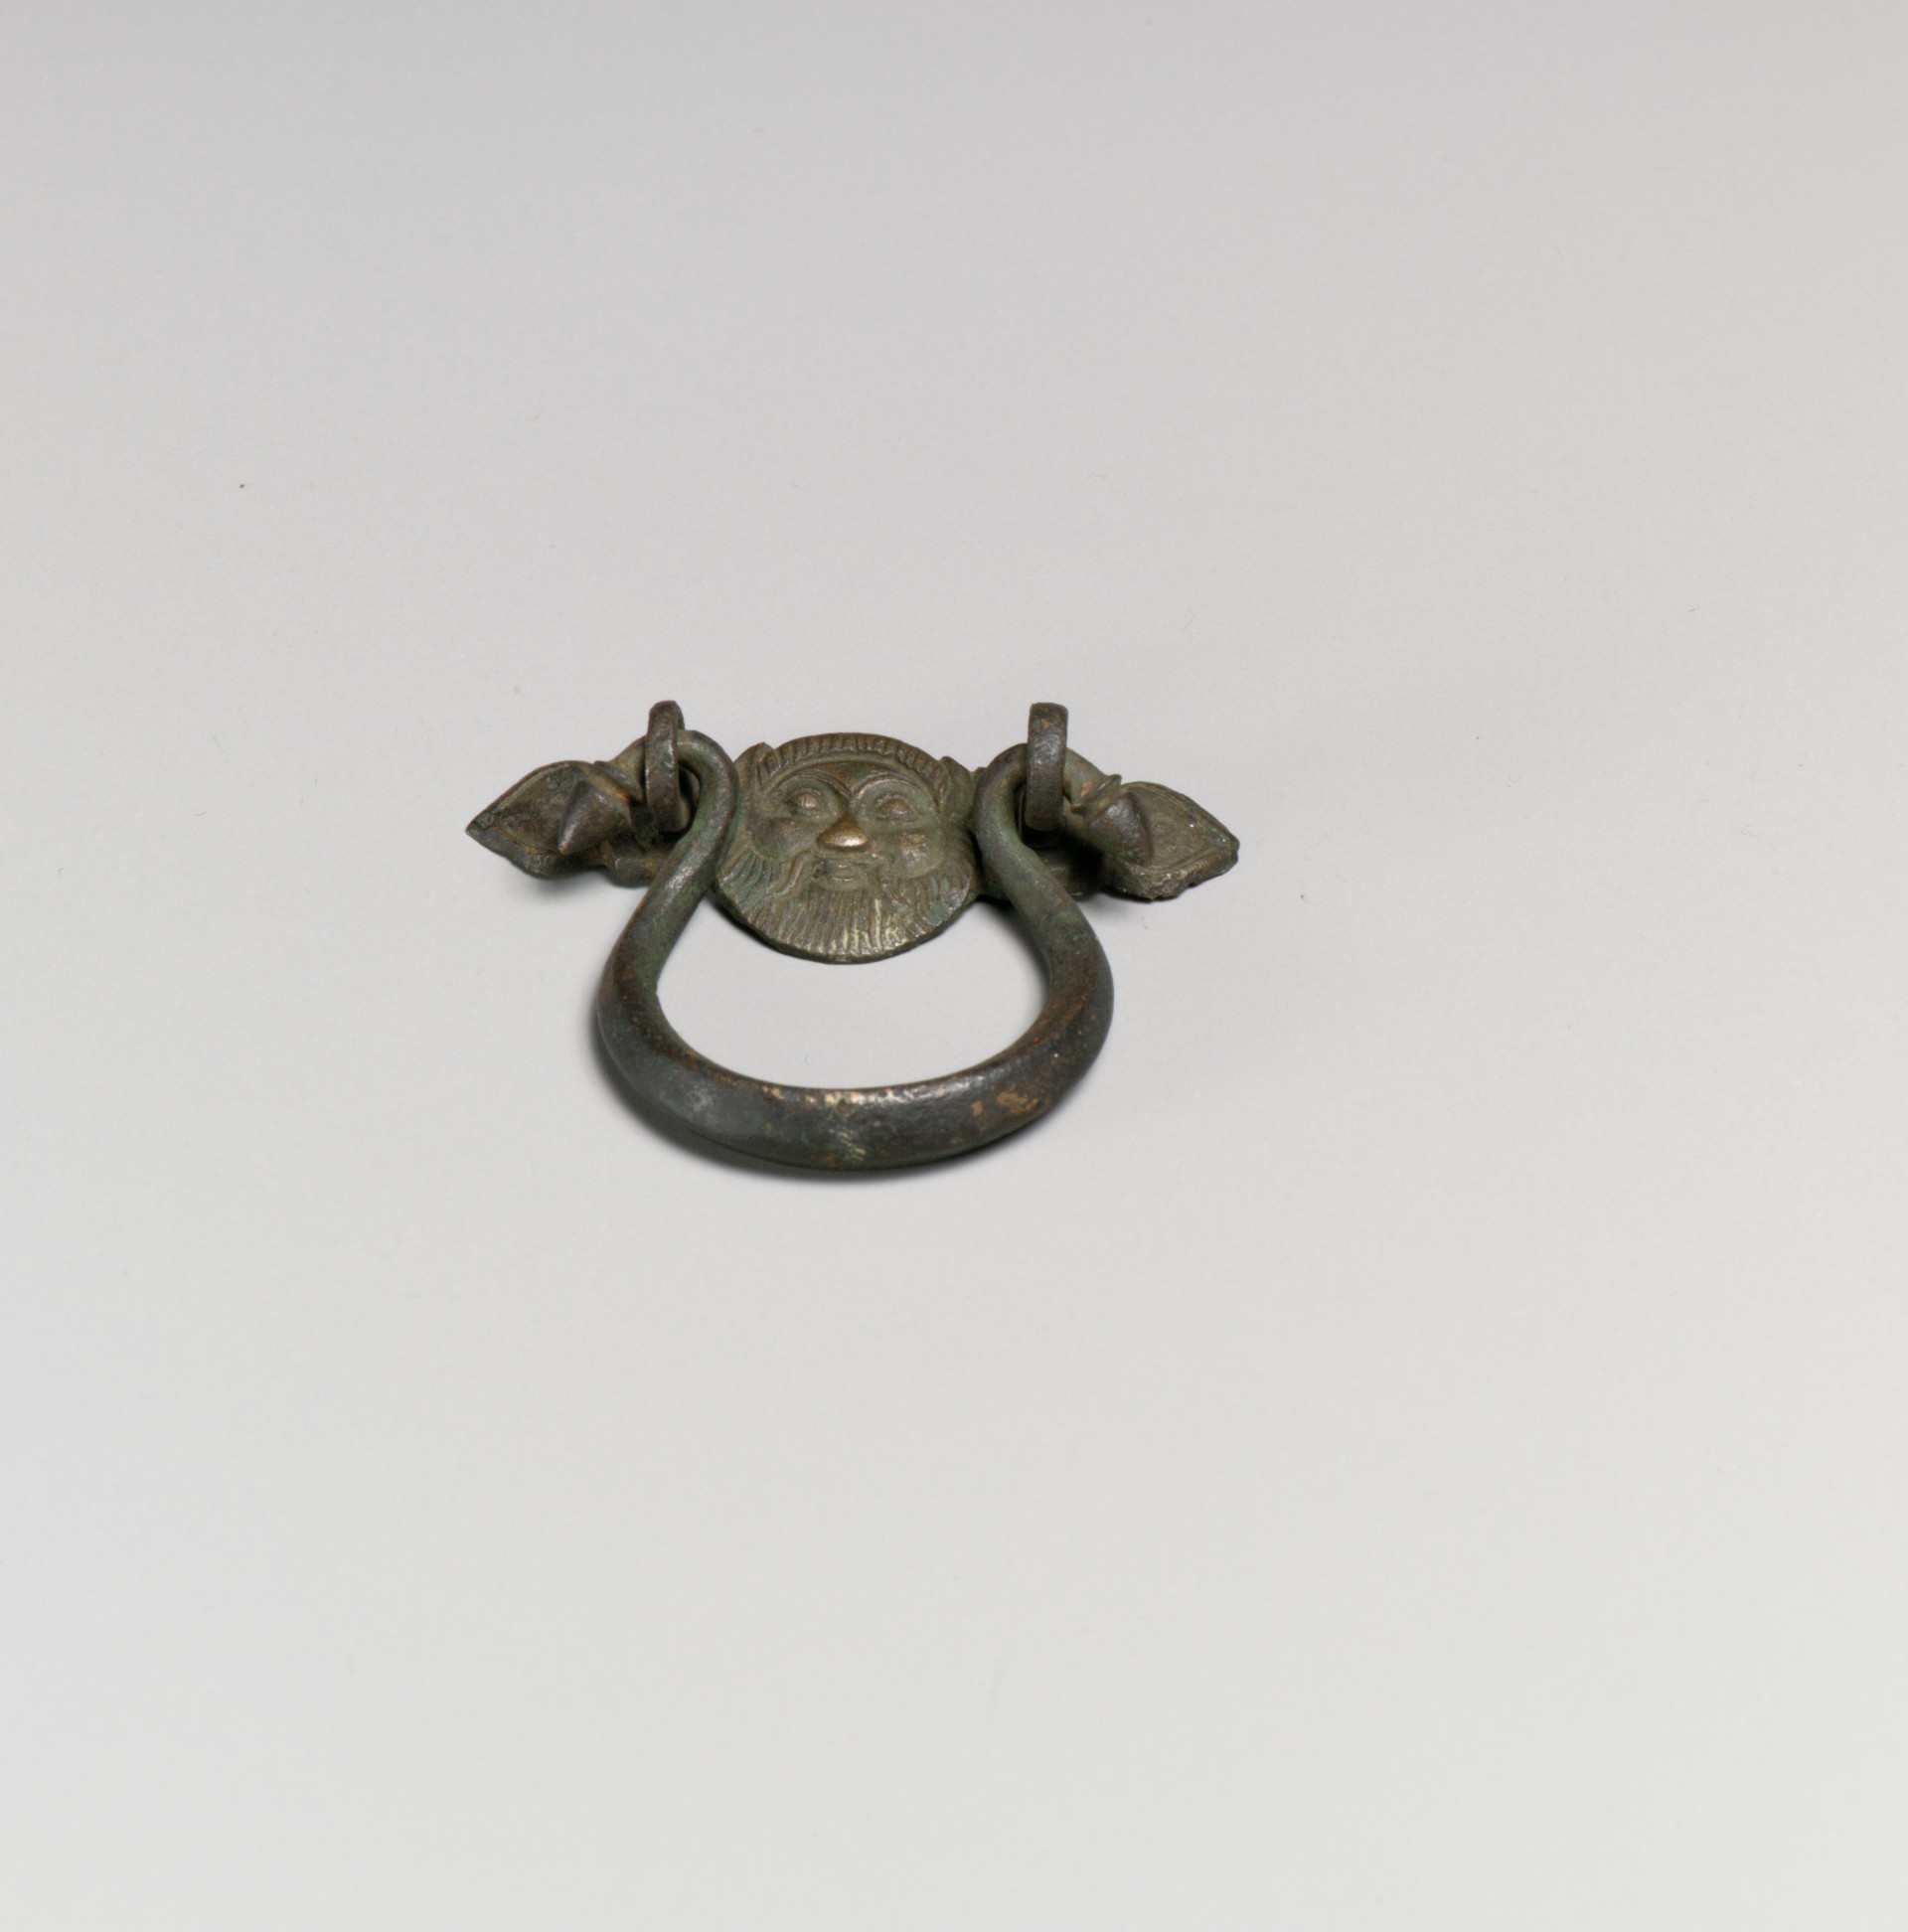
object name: handle with a head of a satyr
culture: etruscan or greek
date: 500-401 BCE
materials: bronze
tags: satyrs